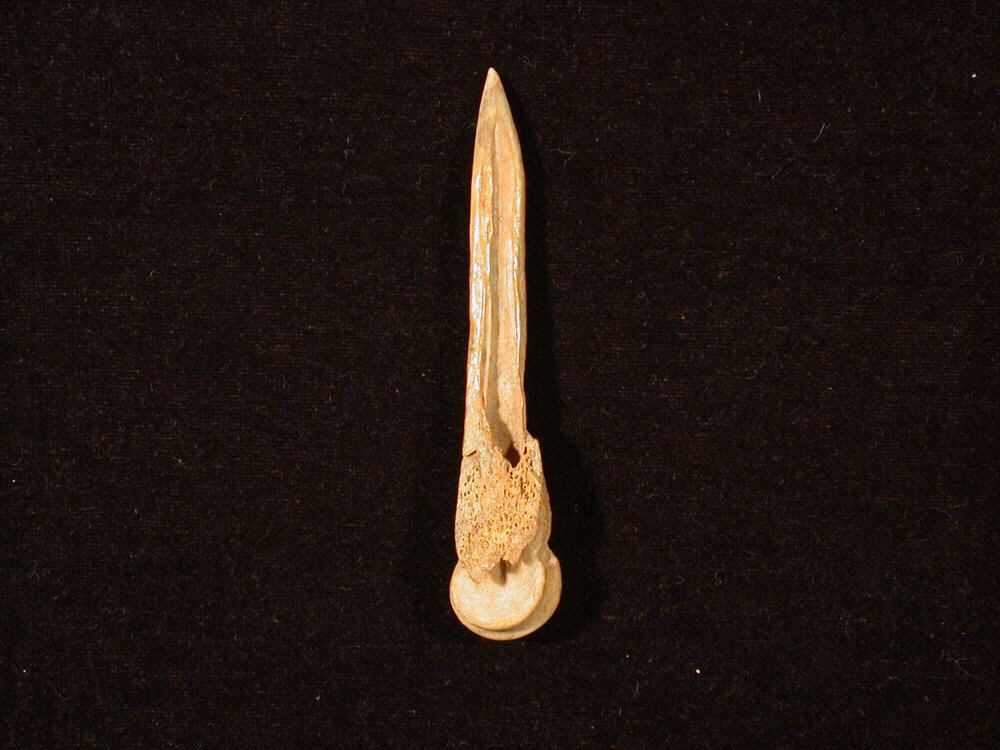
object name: awl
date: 4000-3001 BCE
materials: bone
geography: iran